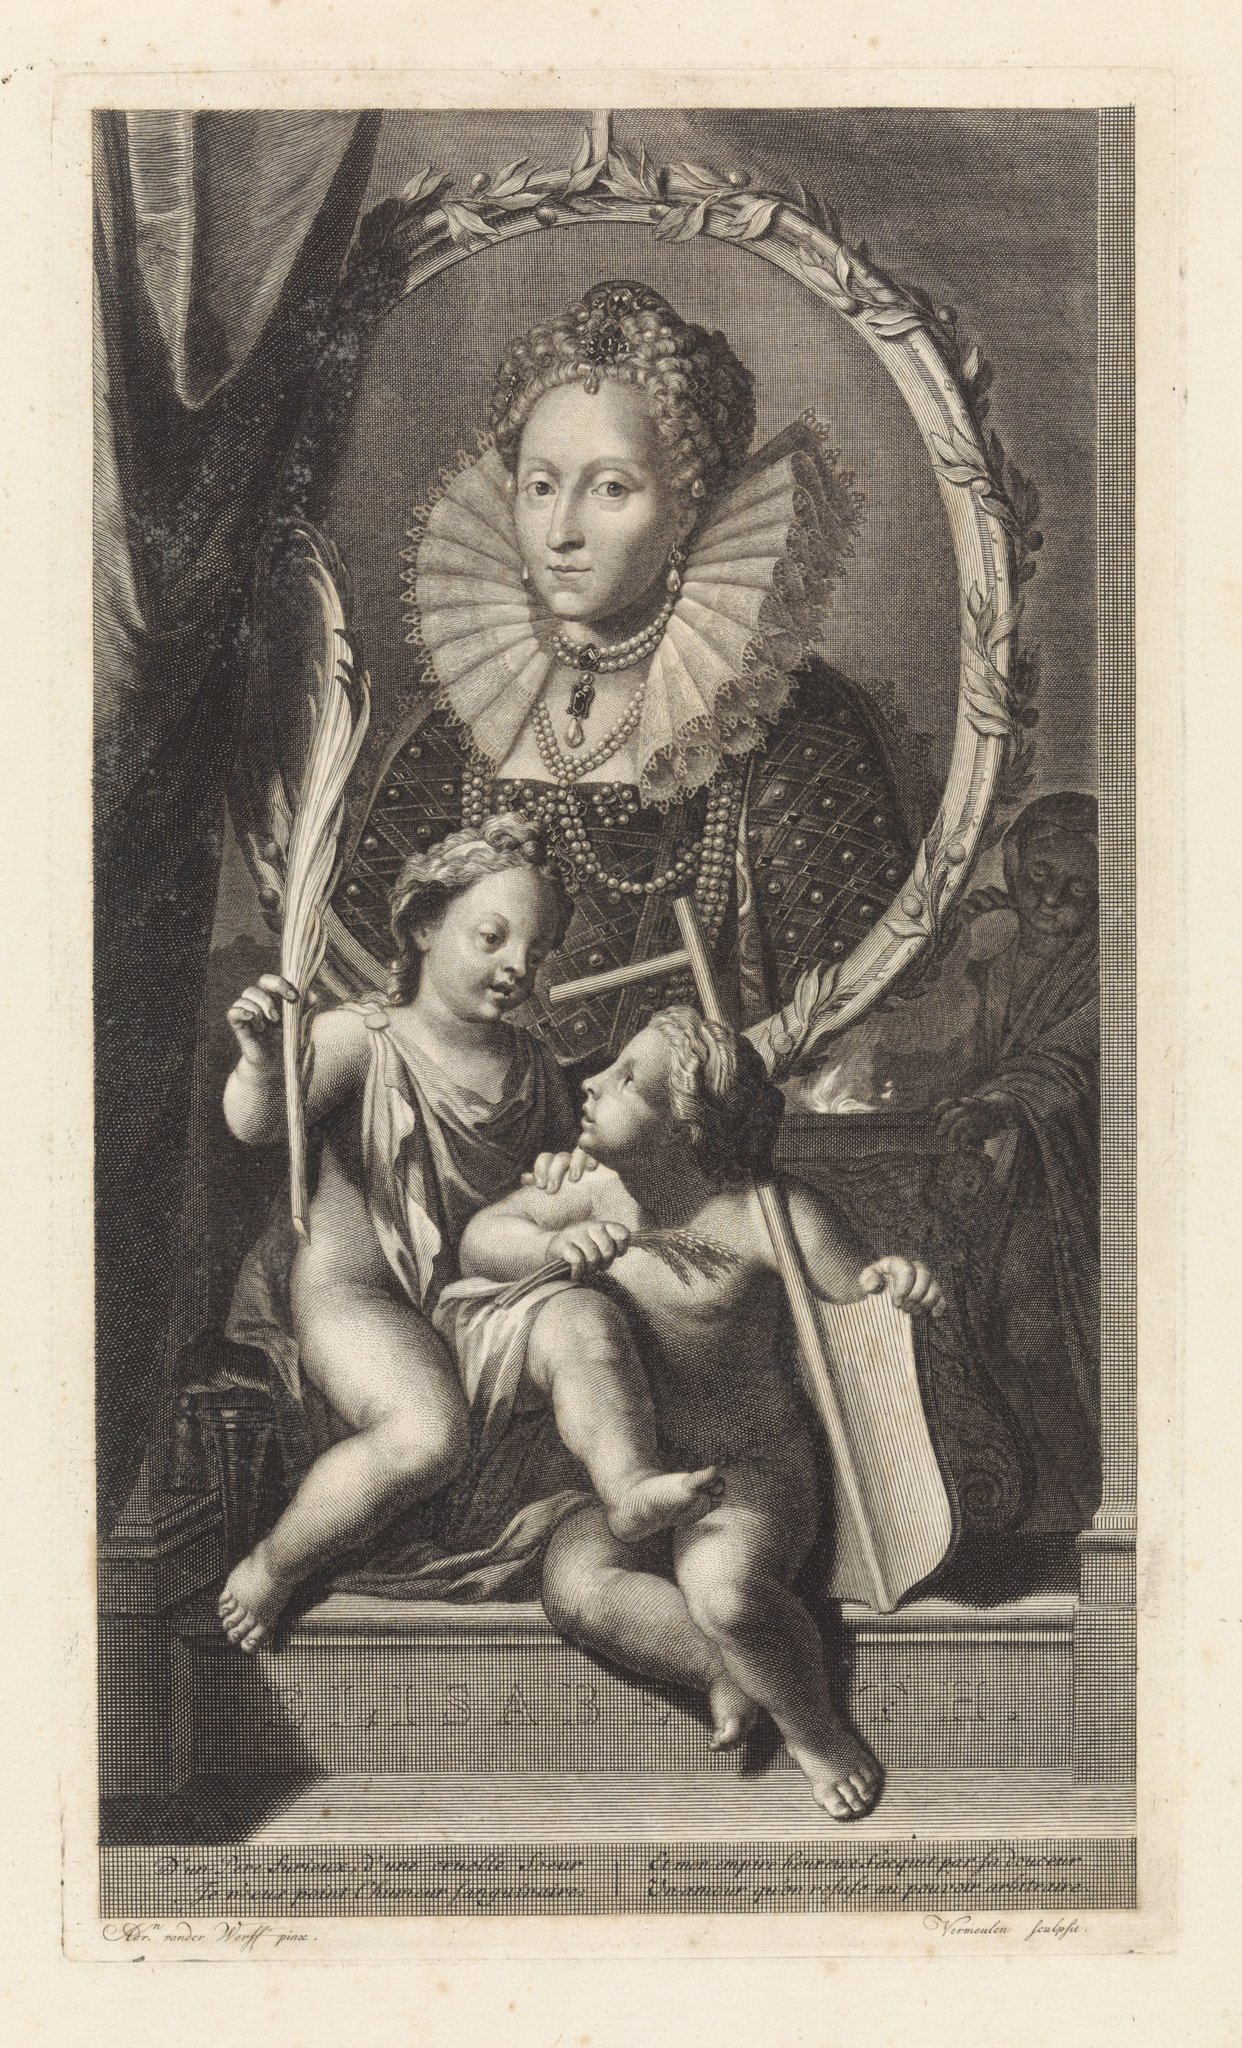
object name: print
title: Elf portretten uit de Engelse geschiedenis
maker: adriaen van der werff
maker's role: draughtsman, painter, print maker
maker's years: 1659-1722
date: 1697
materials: paper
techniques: engraving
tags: parts of ship's exterior: rudder (+ variant), angels crowning and/or bringing palm-branches (+ variant), cupids: 'amores', 'amoretti', 'putti'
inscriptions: collector's mark: Lugt 2228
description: Portret van Elizabeth I Tudor, koningin van Engeland. Op de voorgrond twee putti met een palmtak en een korenaar en een roer, als verwijzingen naar vrede en goed leiderschap.